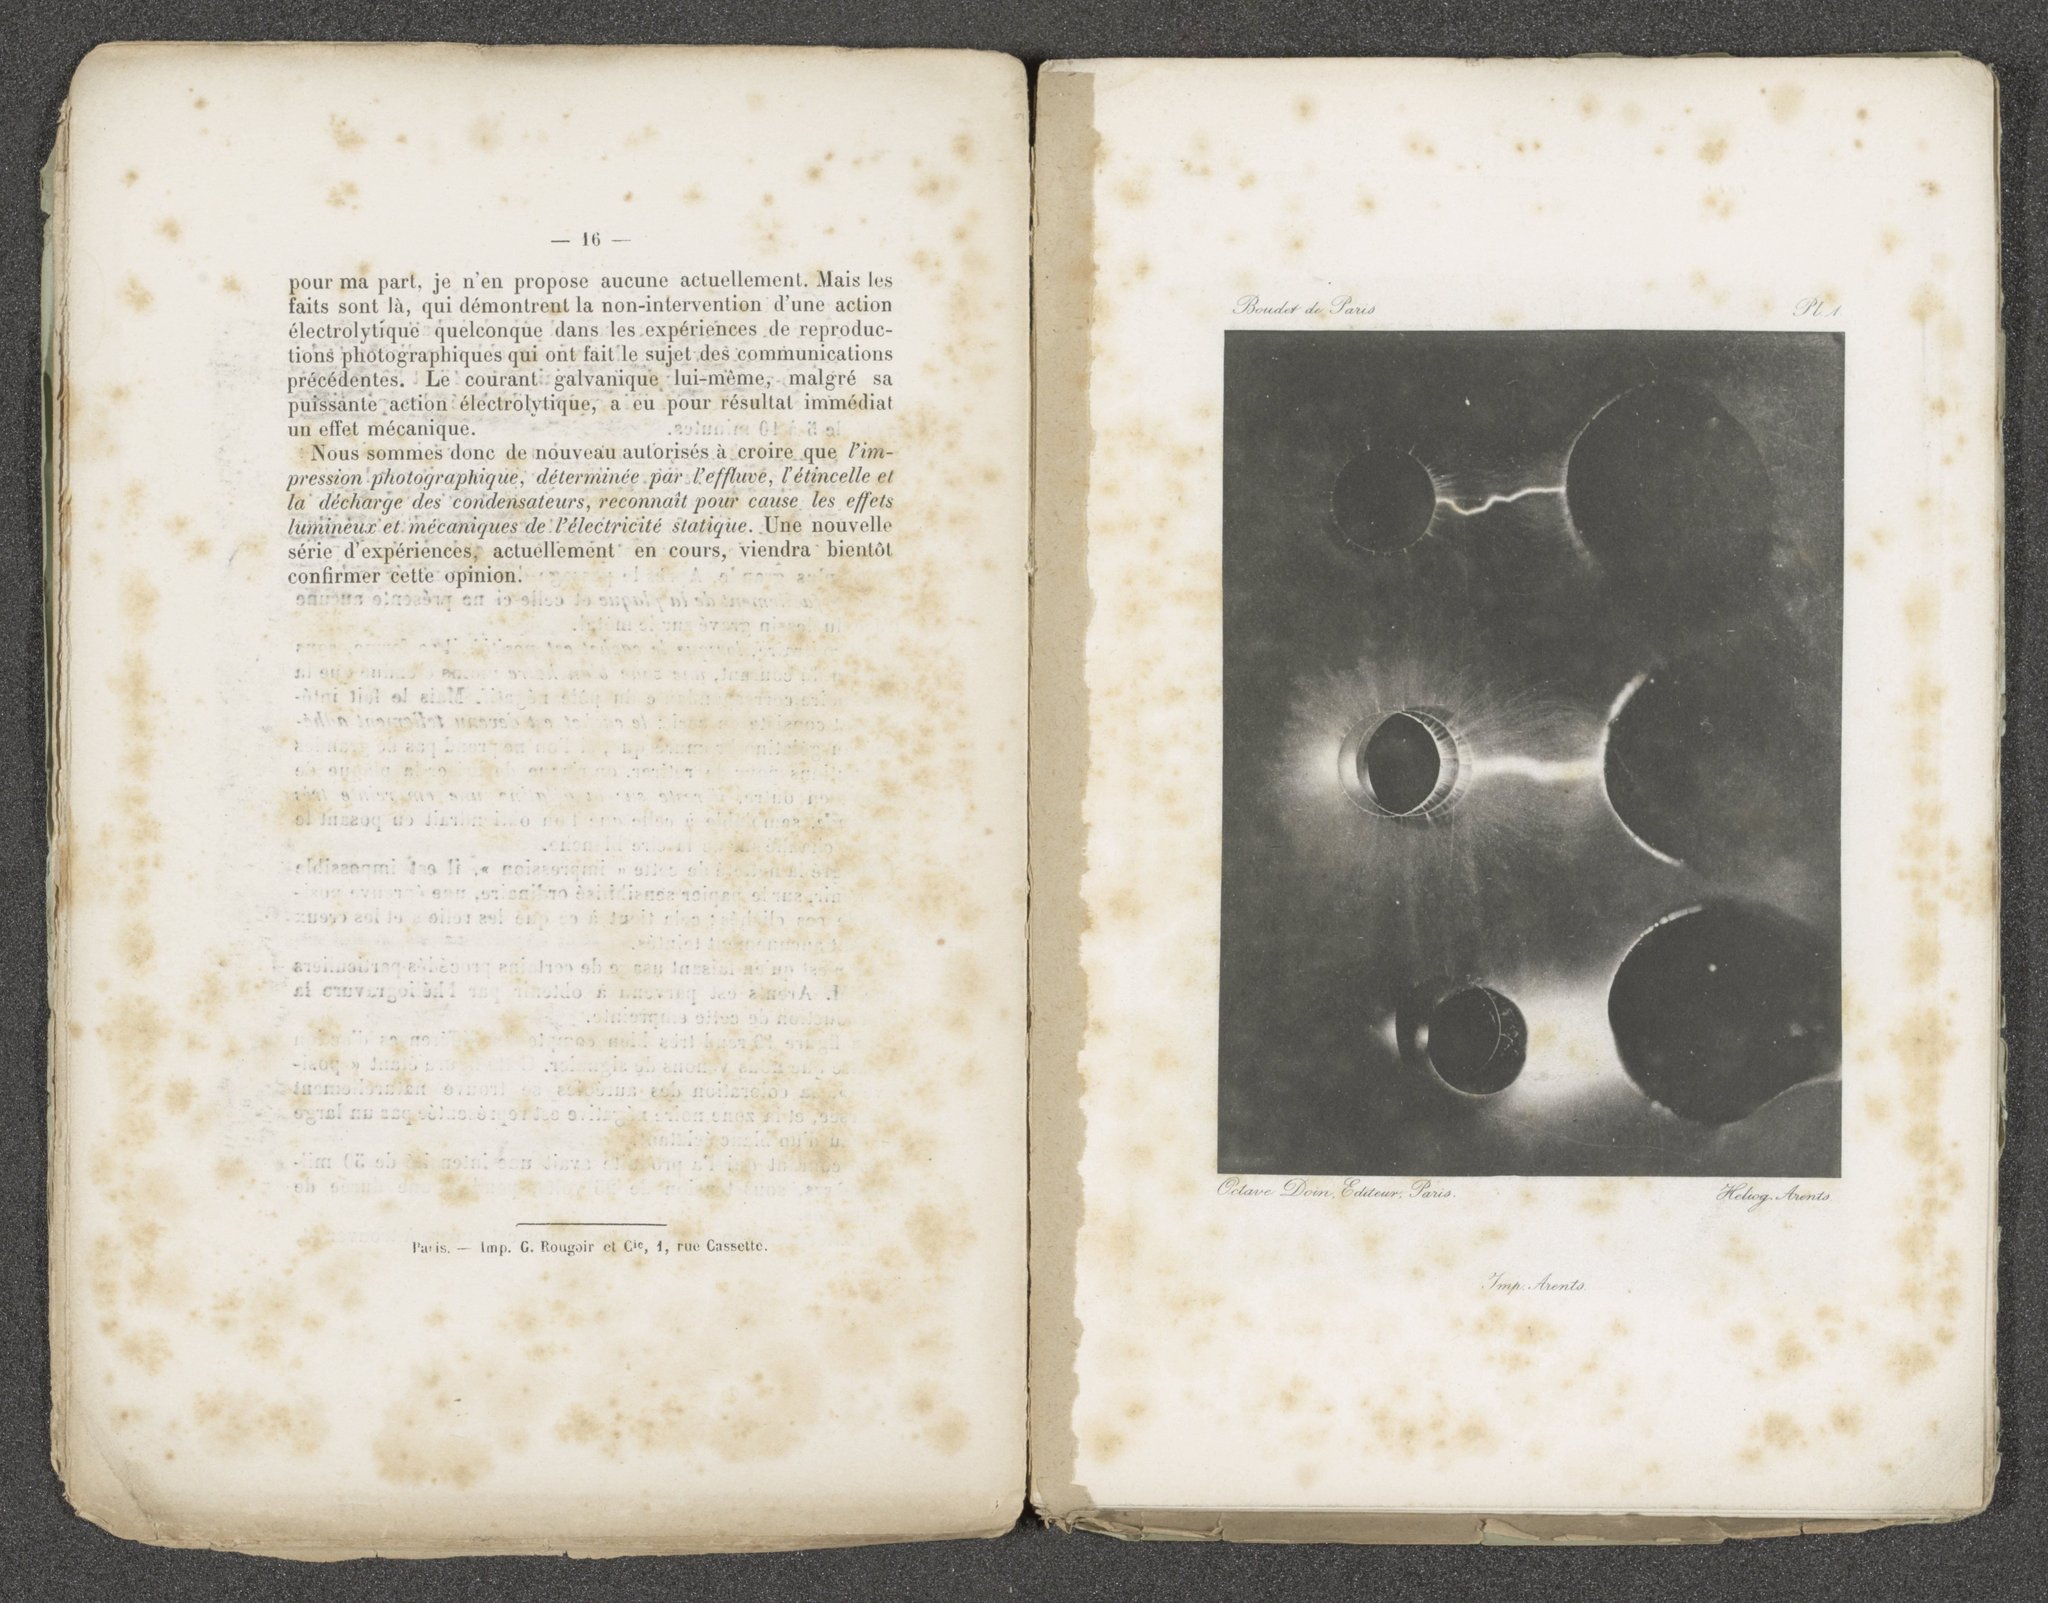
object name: page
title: Elektrische stroom tussen zes munten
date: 1876-1886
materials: paper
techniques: photoaquatint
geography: paris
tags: spark ~ electricity, coin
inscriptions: number: ‘Pl. 1.’